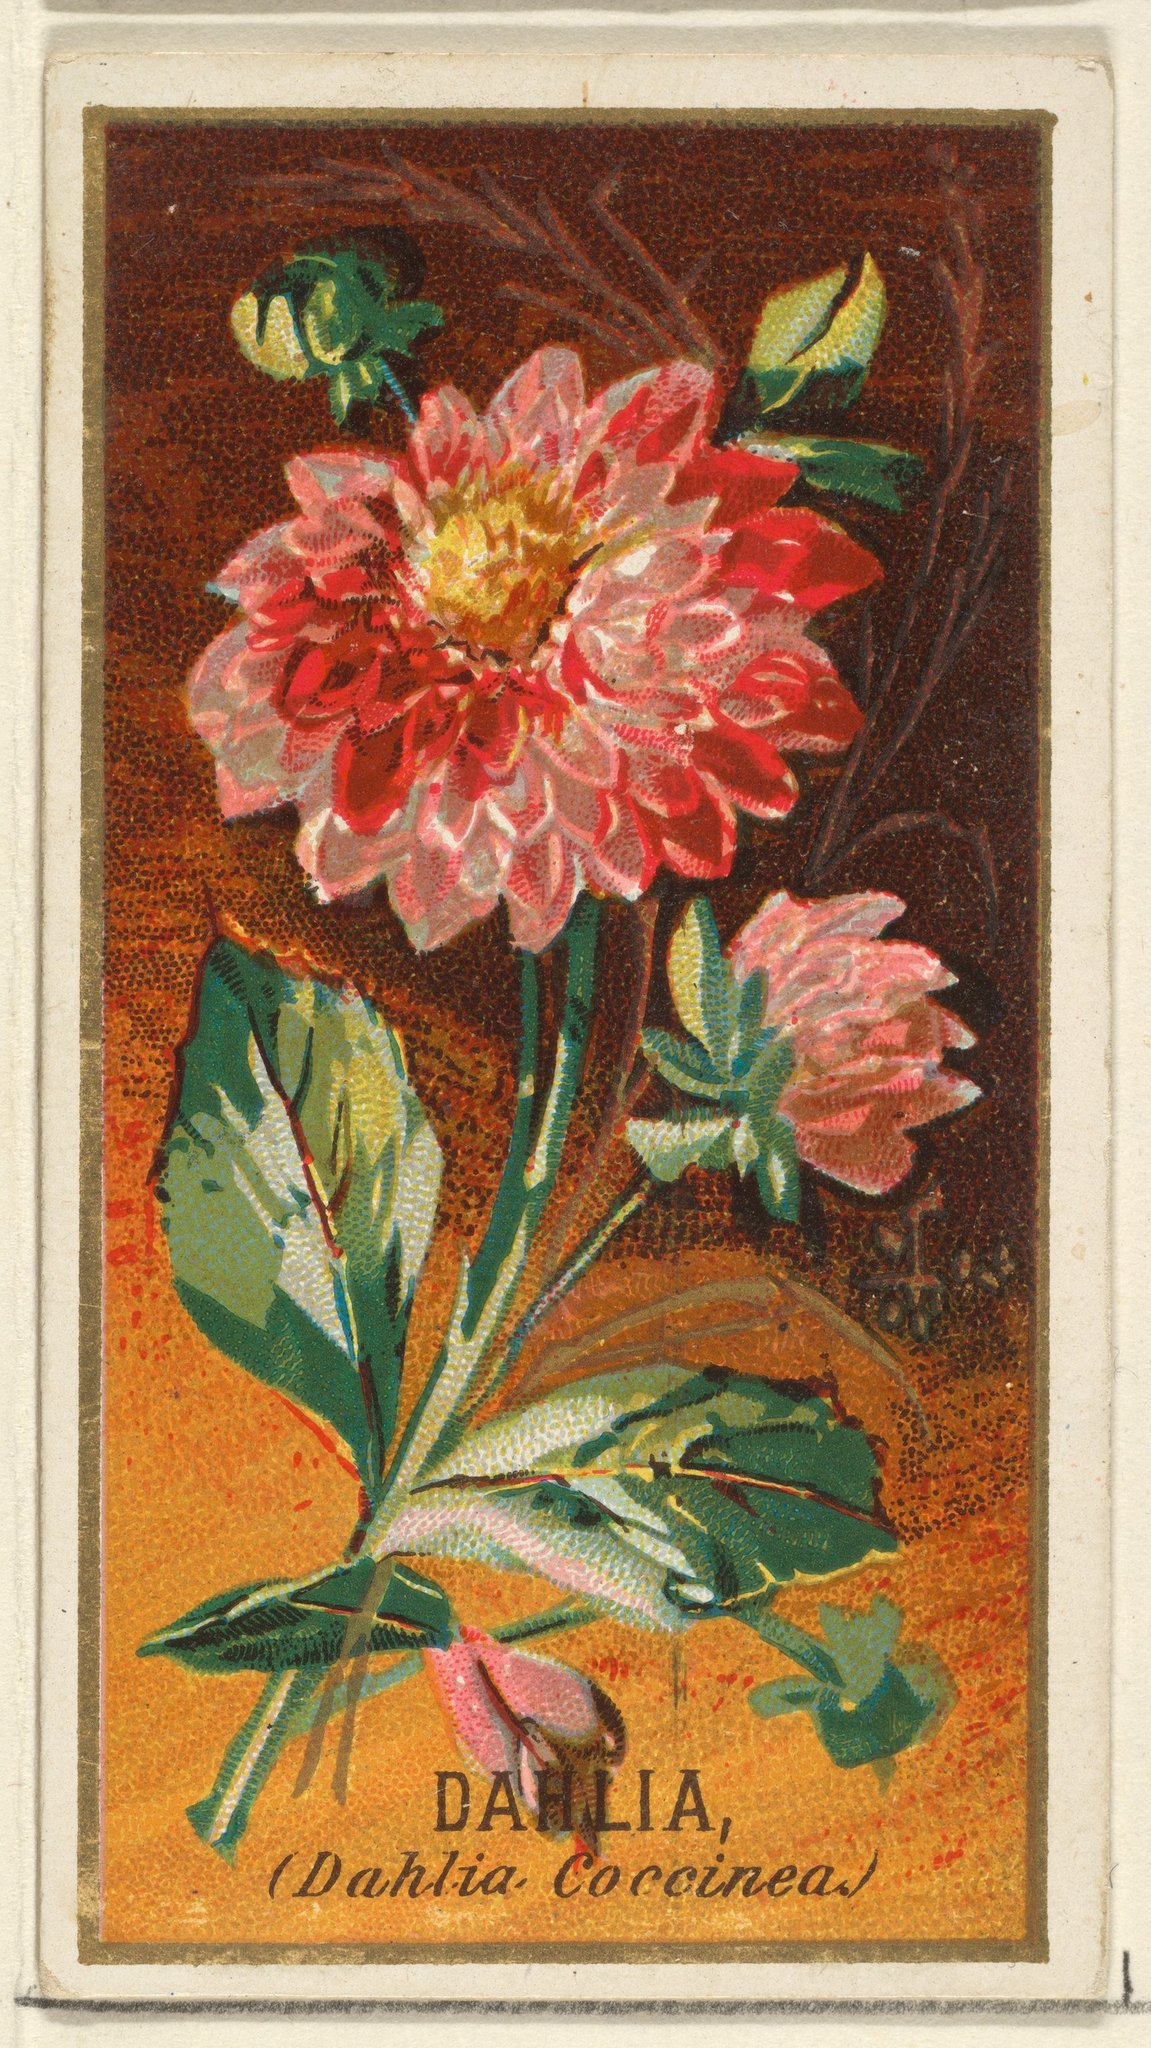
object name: print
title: Dahlia (Dahlia Coccinea), from the Flowers series for Old Judge Cigarettes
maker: goodwin & company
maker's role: publisher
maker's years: 1850-1950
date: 1890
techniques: color lithograph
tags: flowers